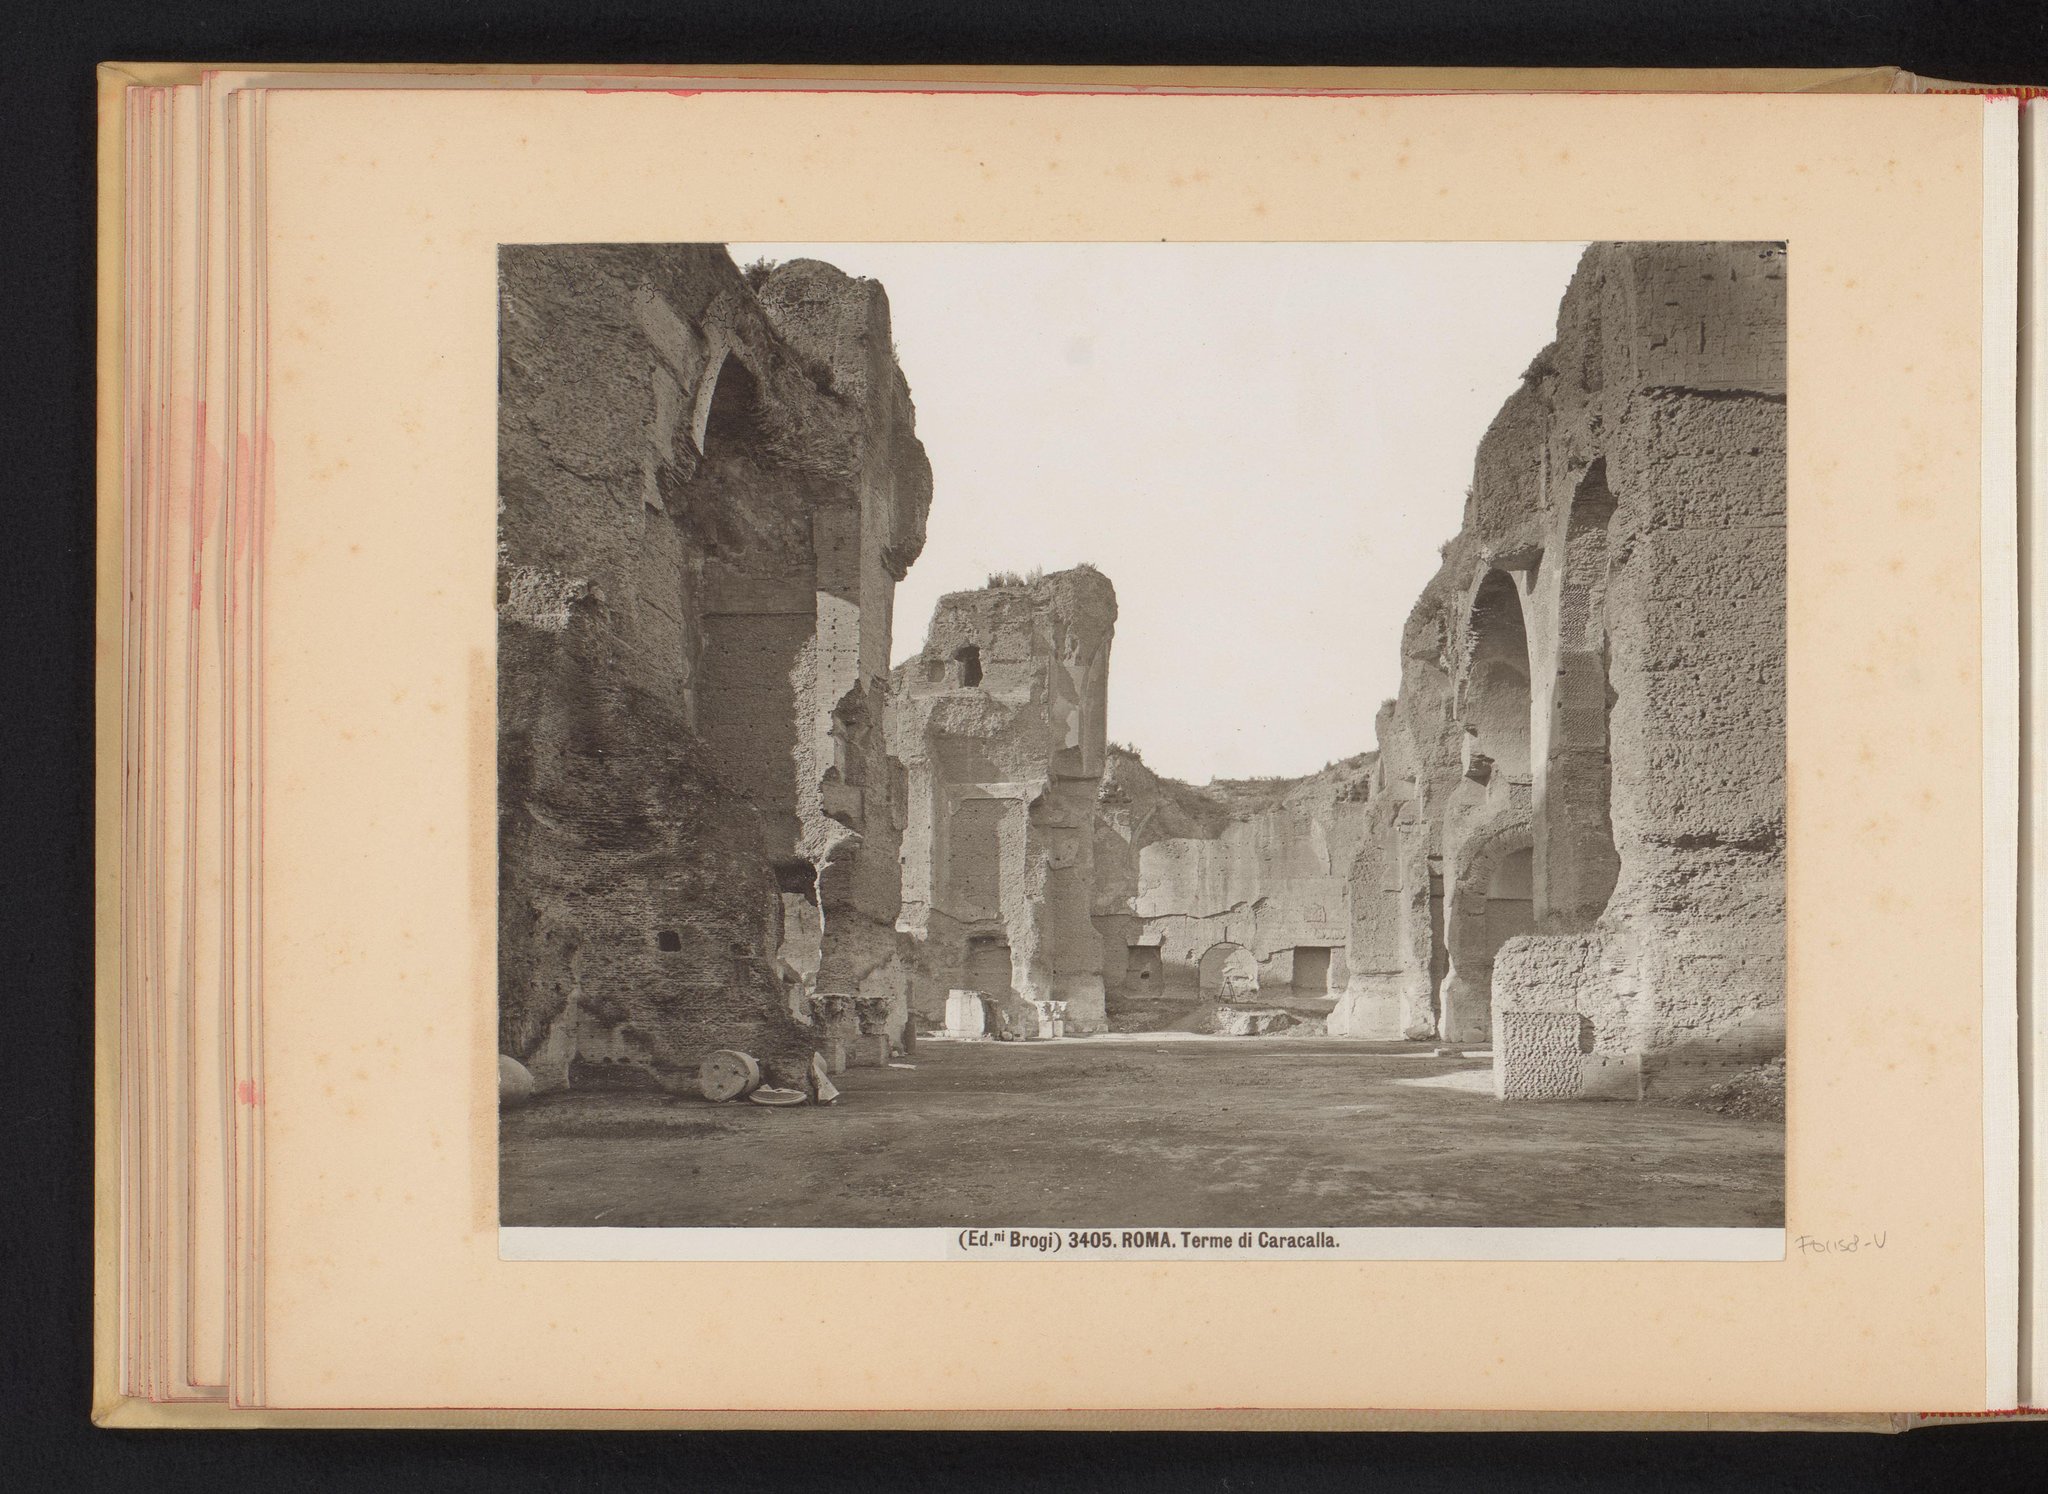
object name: photograph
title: Ruïnes van de Thermen van Caracalla te Rome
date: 1875-1900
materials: photographic support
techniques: gelatin silver print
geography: rome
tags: ruin of a building ~ architecture, public baths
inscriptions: number: ‘3405’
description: Onderdeel van Fotoalbum met opnames van bezienswaardigheden en kunstwerken in Italië.